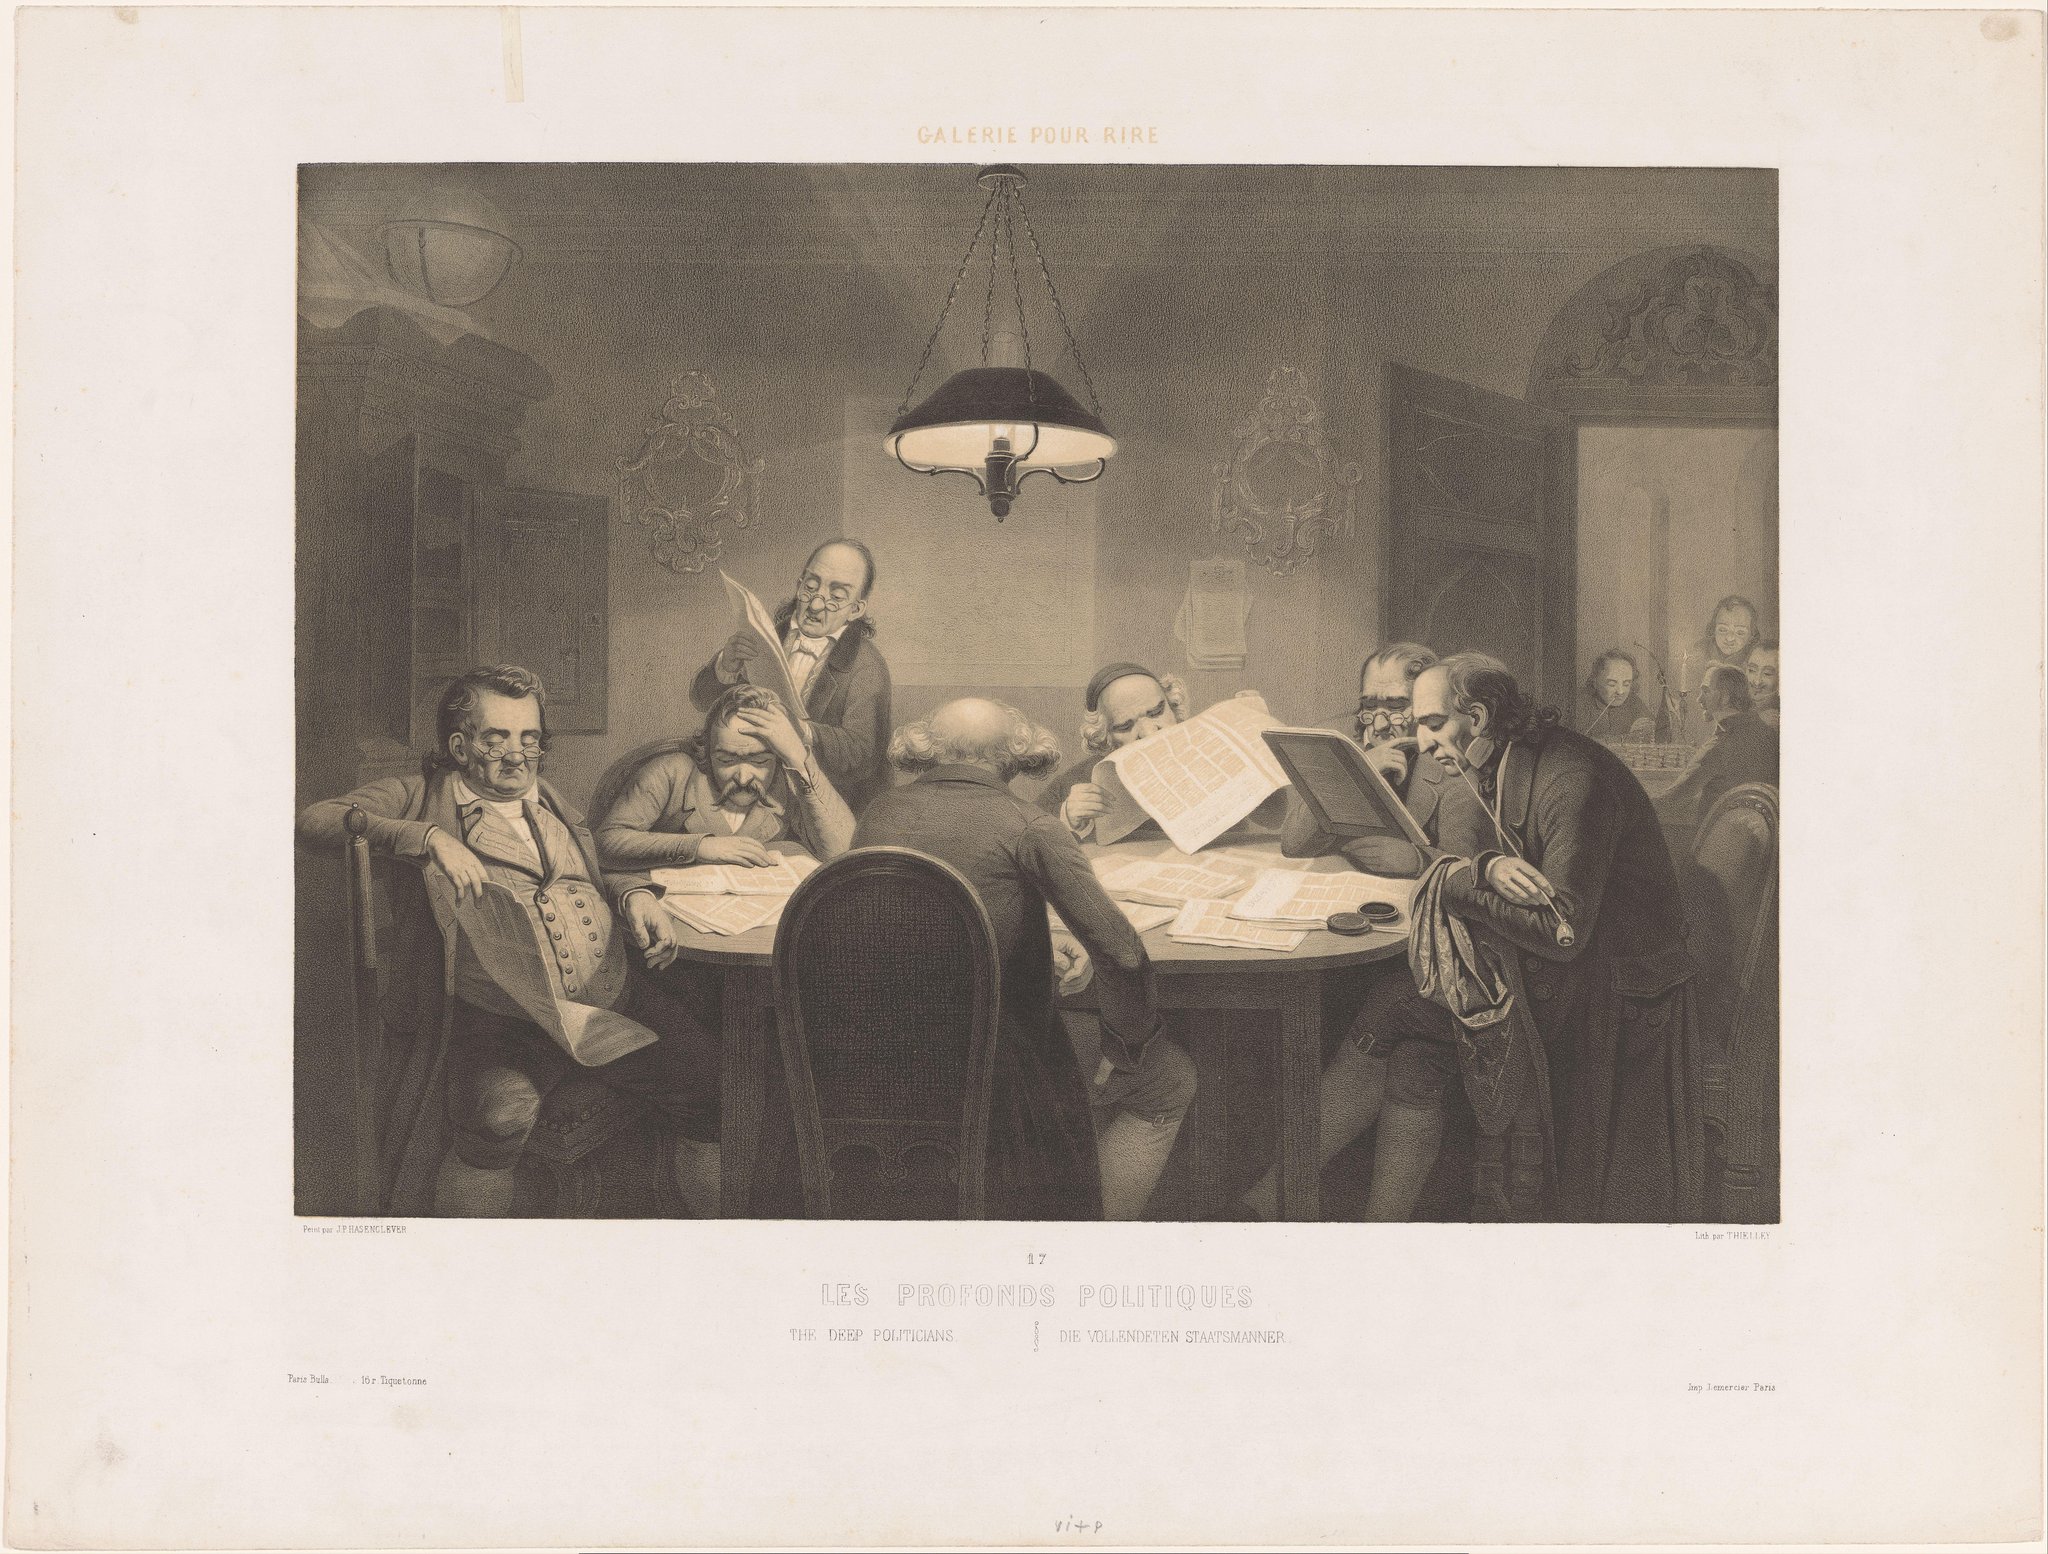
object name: print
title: Lezende mannen rond een tafel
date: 1847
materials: paper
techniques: tone lithography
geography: paris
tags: reading, chess, pipe ~ tobacco, oil-lamp, newspaper, news-sheet, political caricatures and satires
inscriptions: collector's mark: Lugt 4779, collector's mark: Lugt 2228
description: Interieur met zeven mannen rond een tafel, lezend in dagbladen. Boven de tafel hangt een olielamp. Een van de mannen rookt een lange pijp. In de achtergrond een doorkijk naar een ander vertrek waar mannen zitten te schaken.